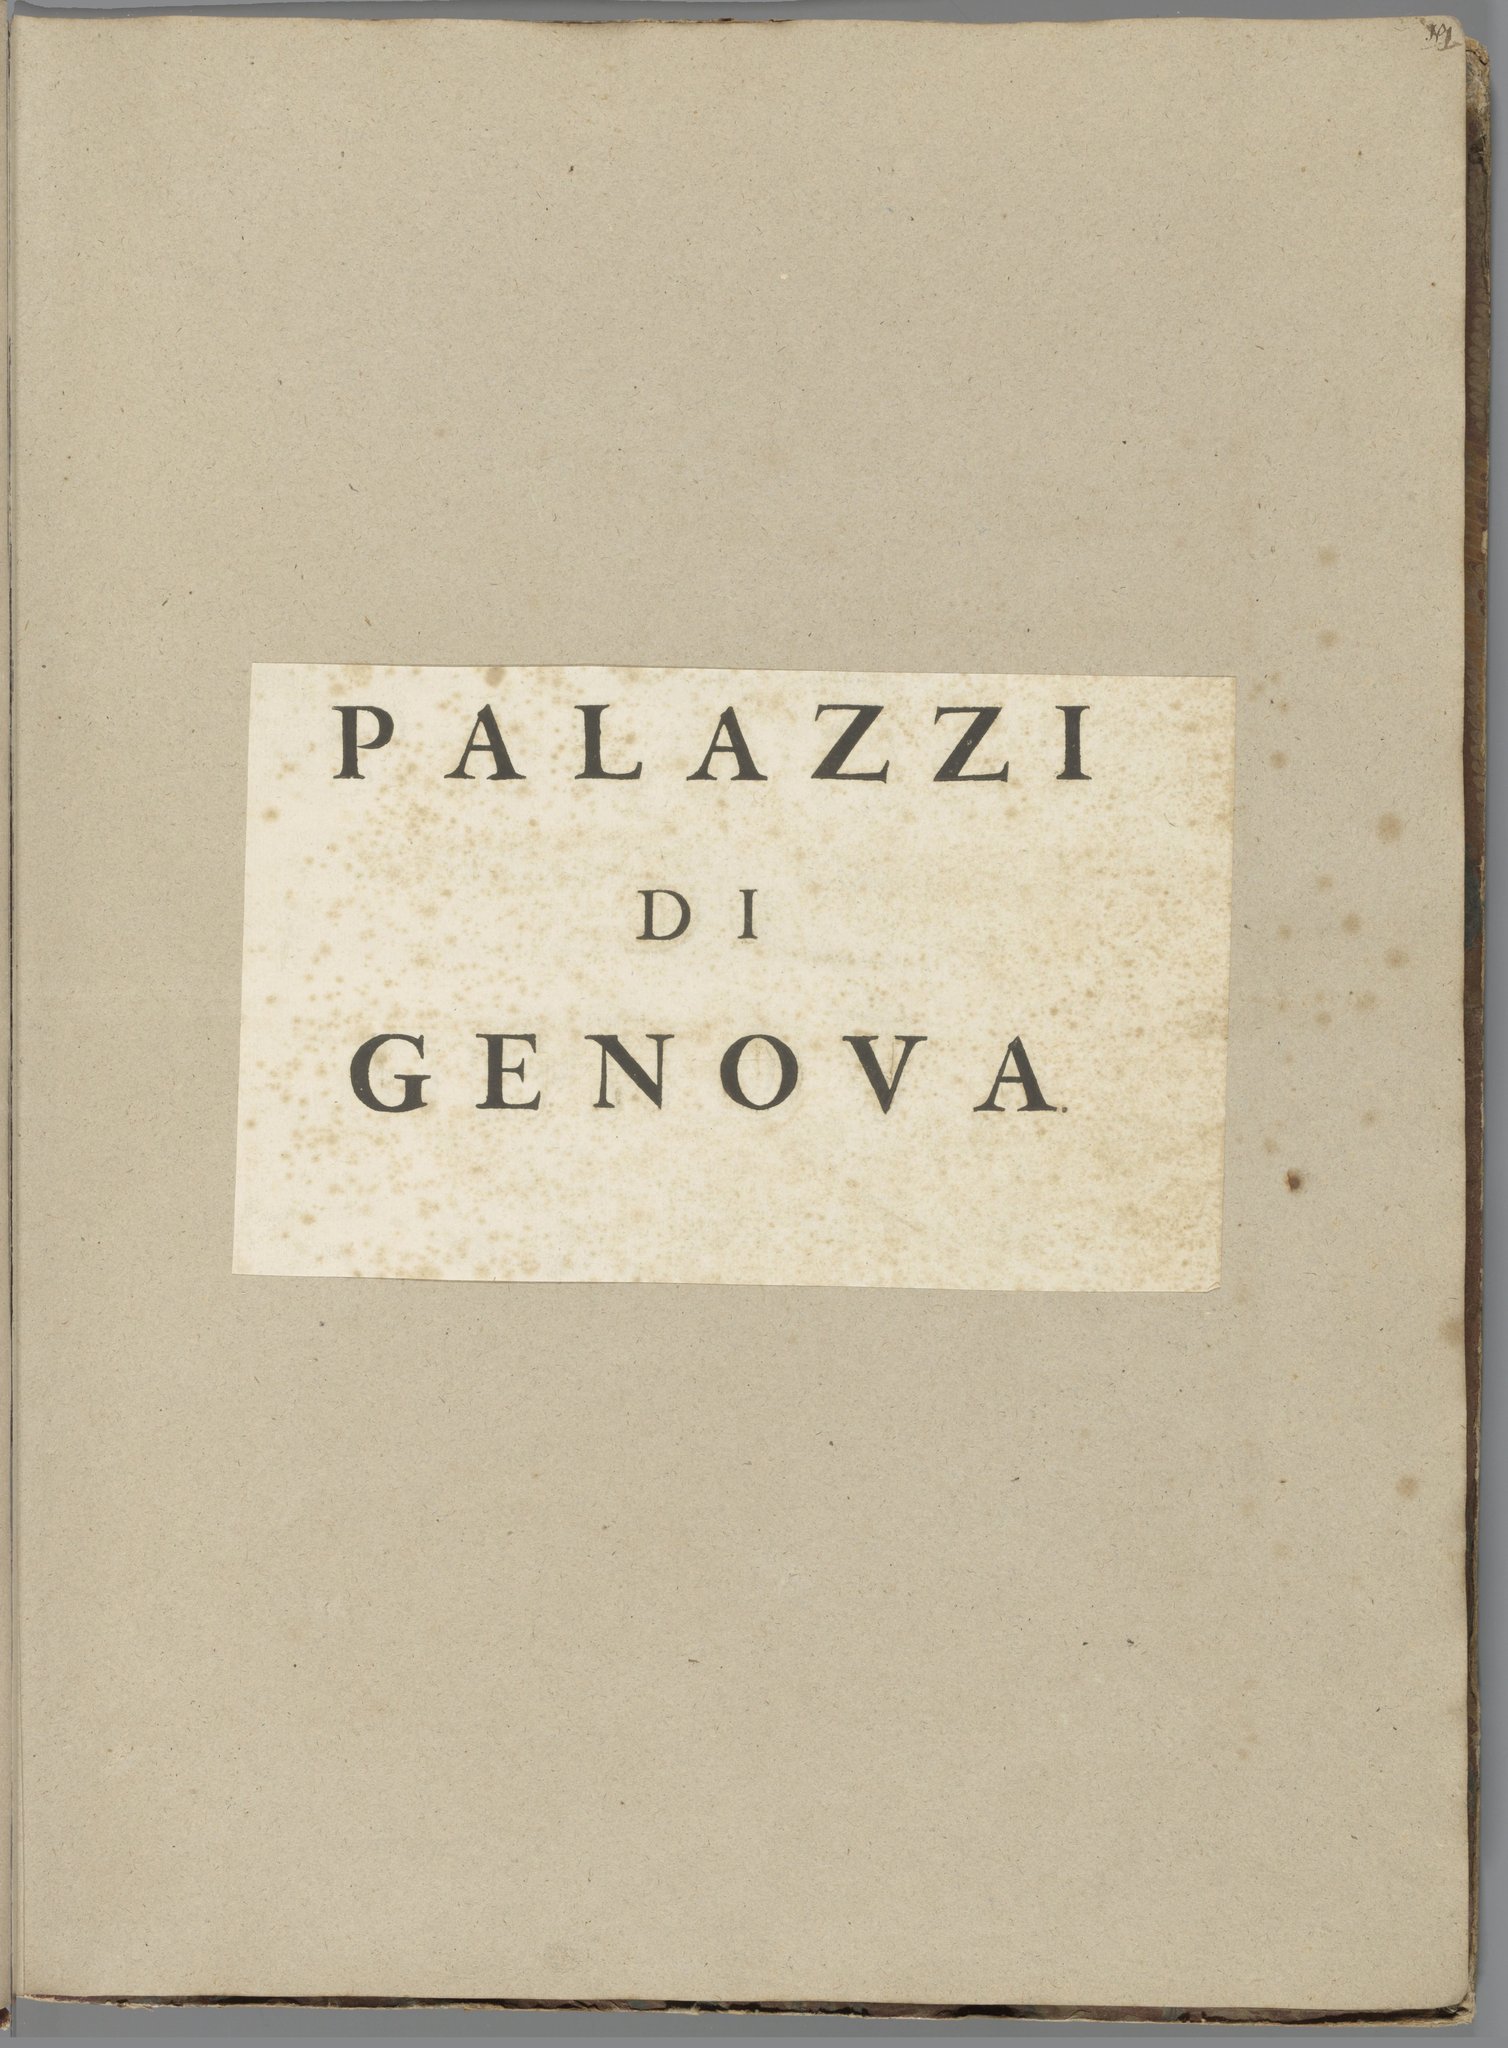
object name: text sheet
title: Palazzi di Genova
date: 1622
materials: paper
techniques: letterpress printing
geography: antwerp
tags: title-page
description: Titelpagina van het eerste deel met 'Palazzi Antichi'. Dit blad maakt deel uit van een album.